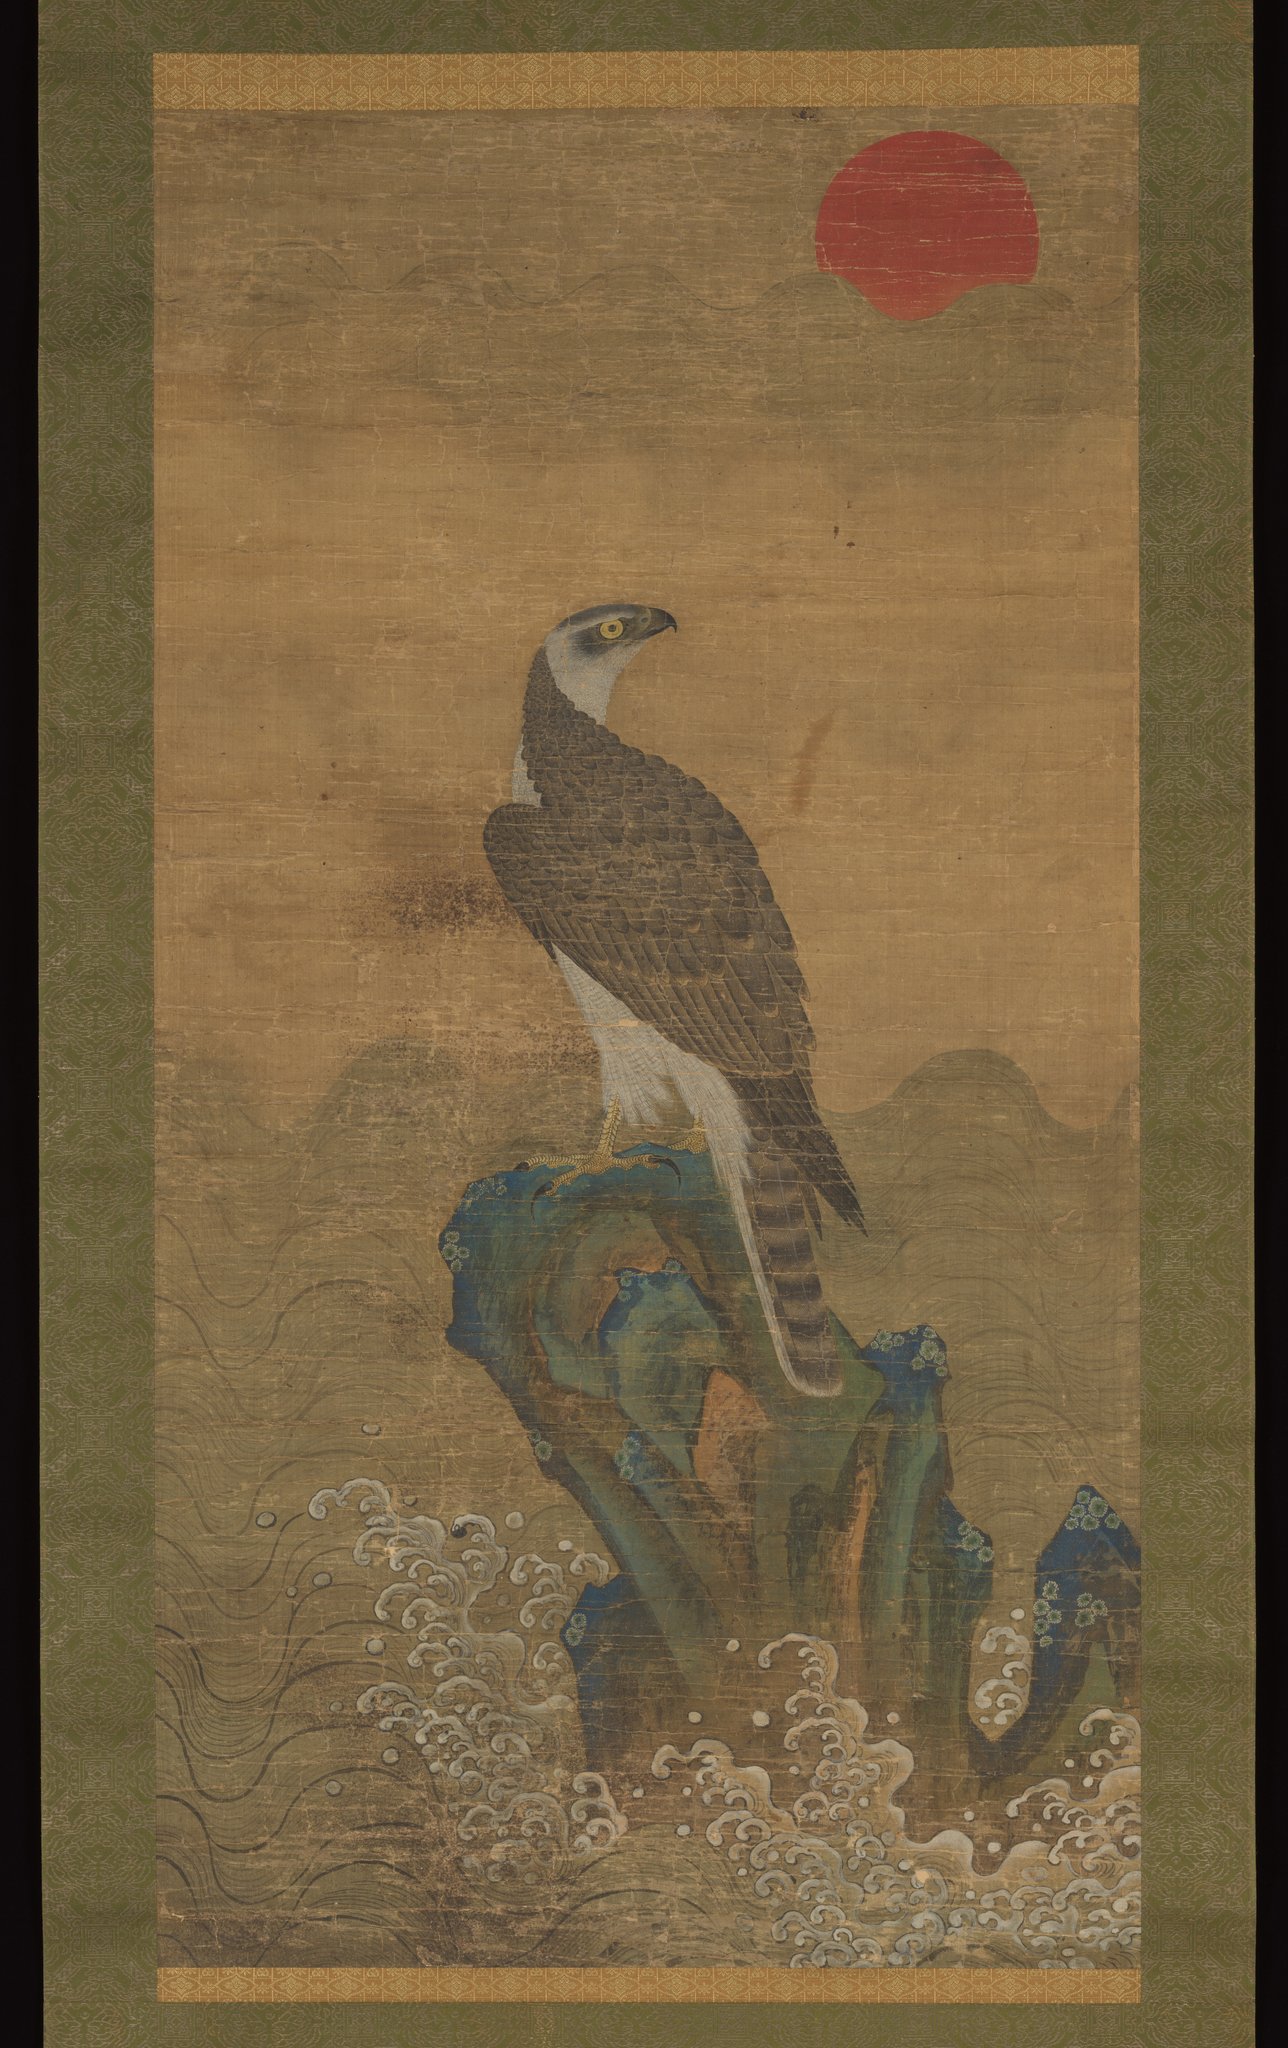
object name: hanging scroll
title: Hawk at Sunrise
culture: korean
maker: jeong hong-rae 정홍래 鄭弘來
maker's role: artist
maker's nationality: korean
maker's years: 1720-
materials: ink, silk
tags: hawks